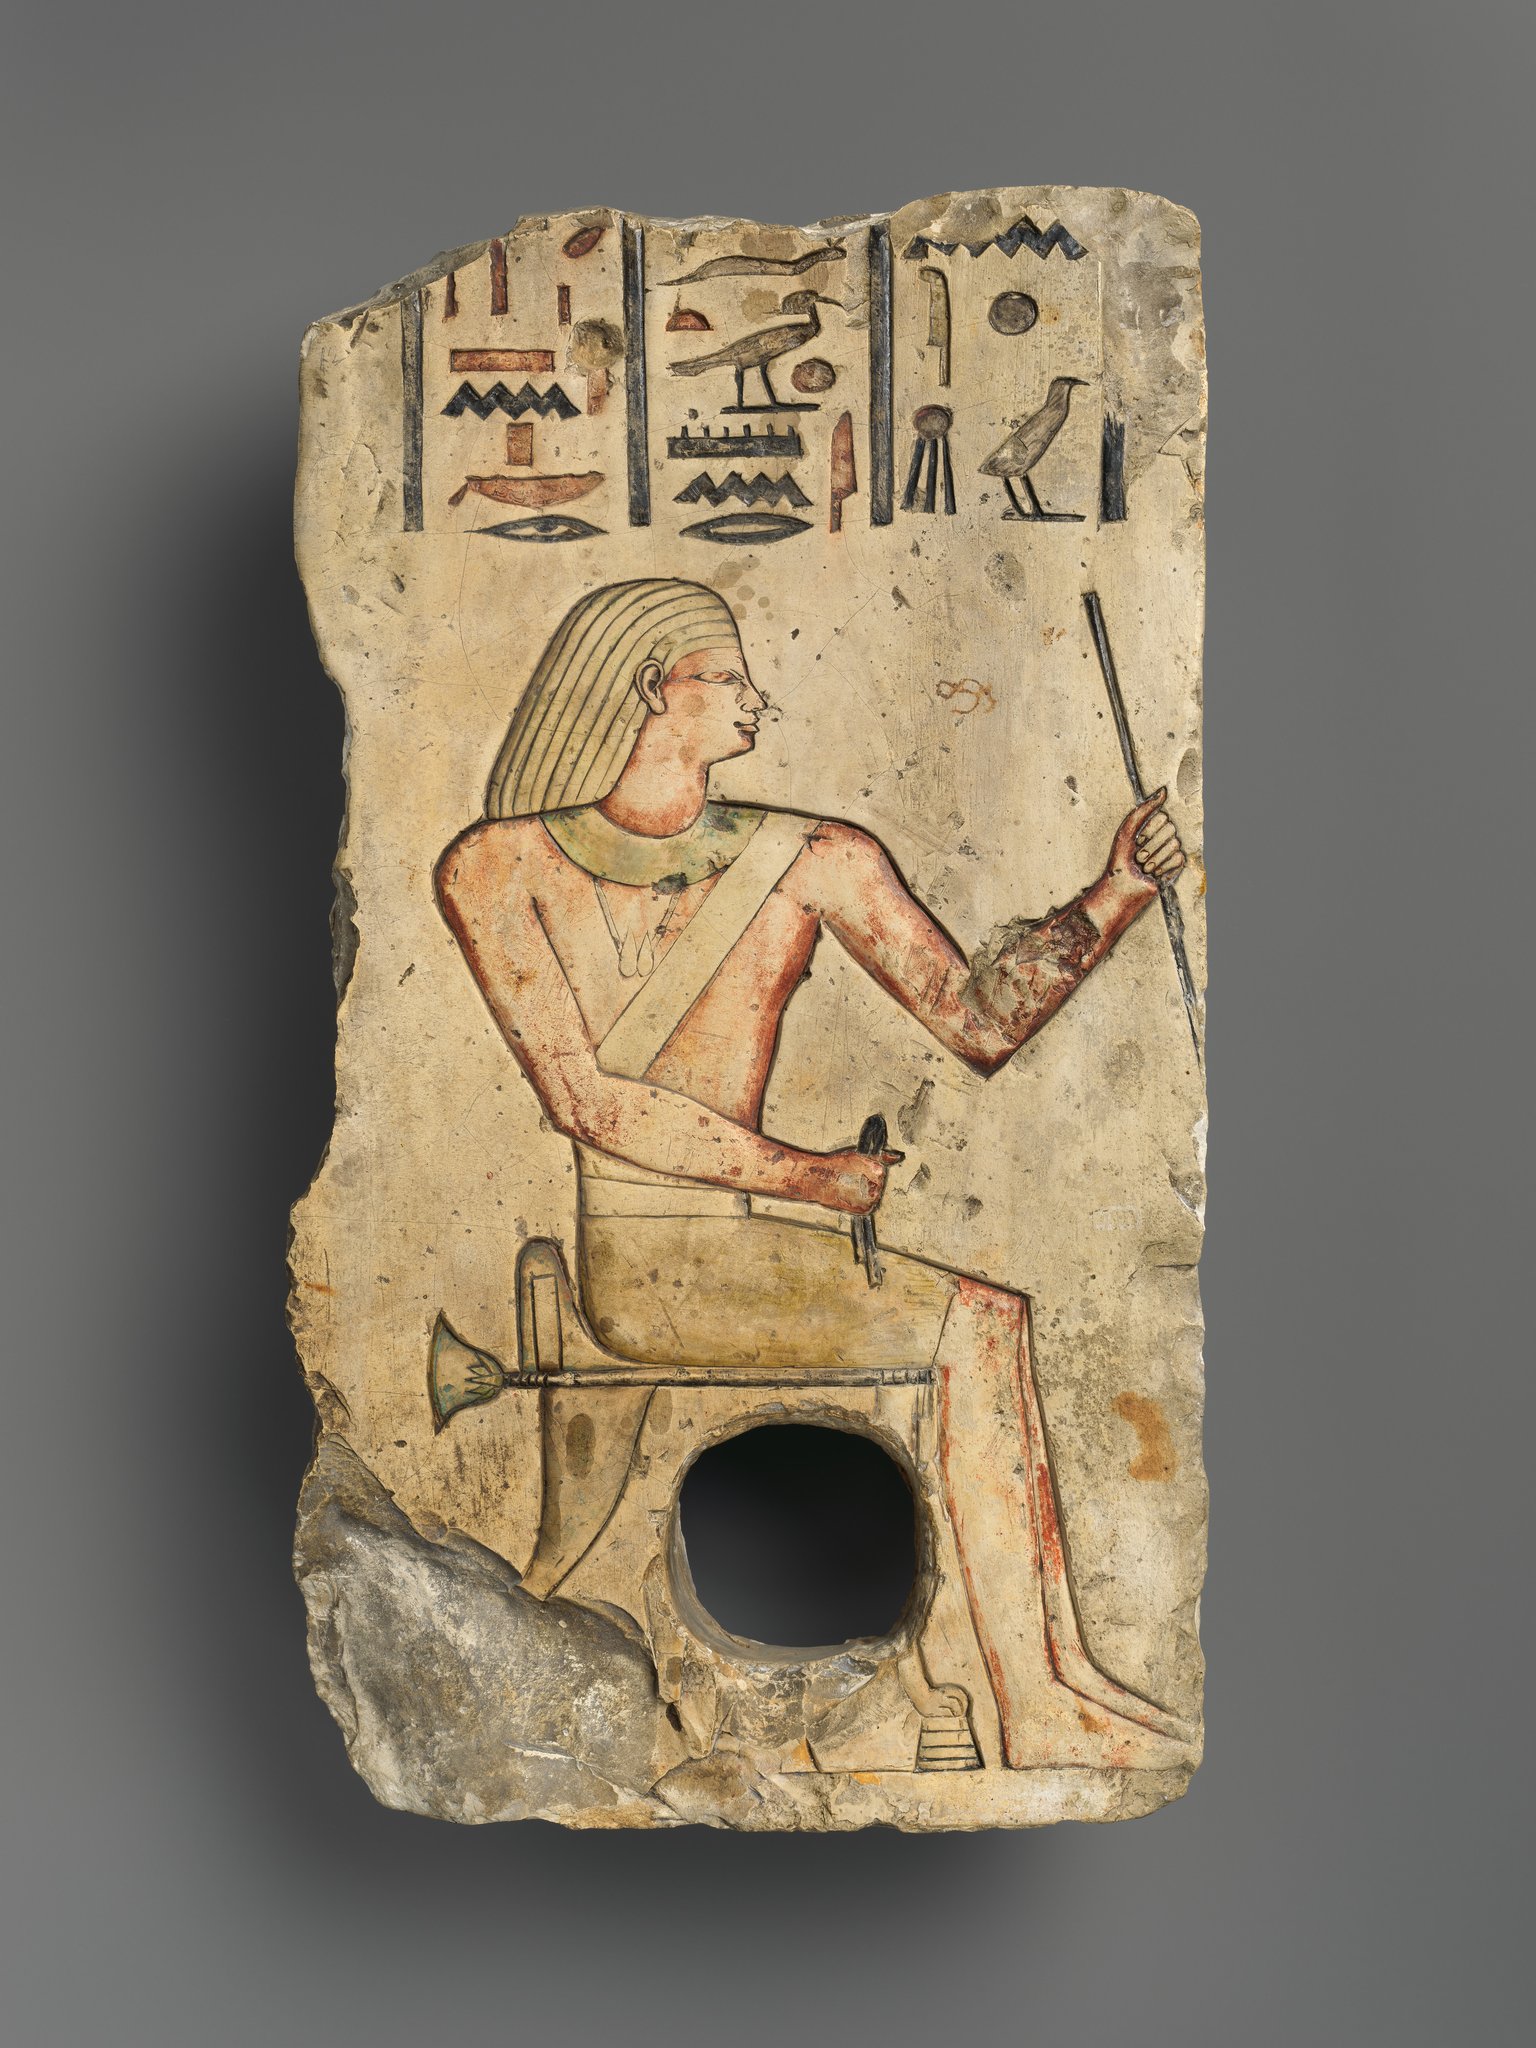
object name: relief, akhamenru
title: Relief of Seated Akhamenru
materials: limestone, paint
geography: egypt